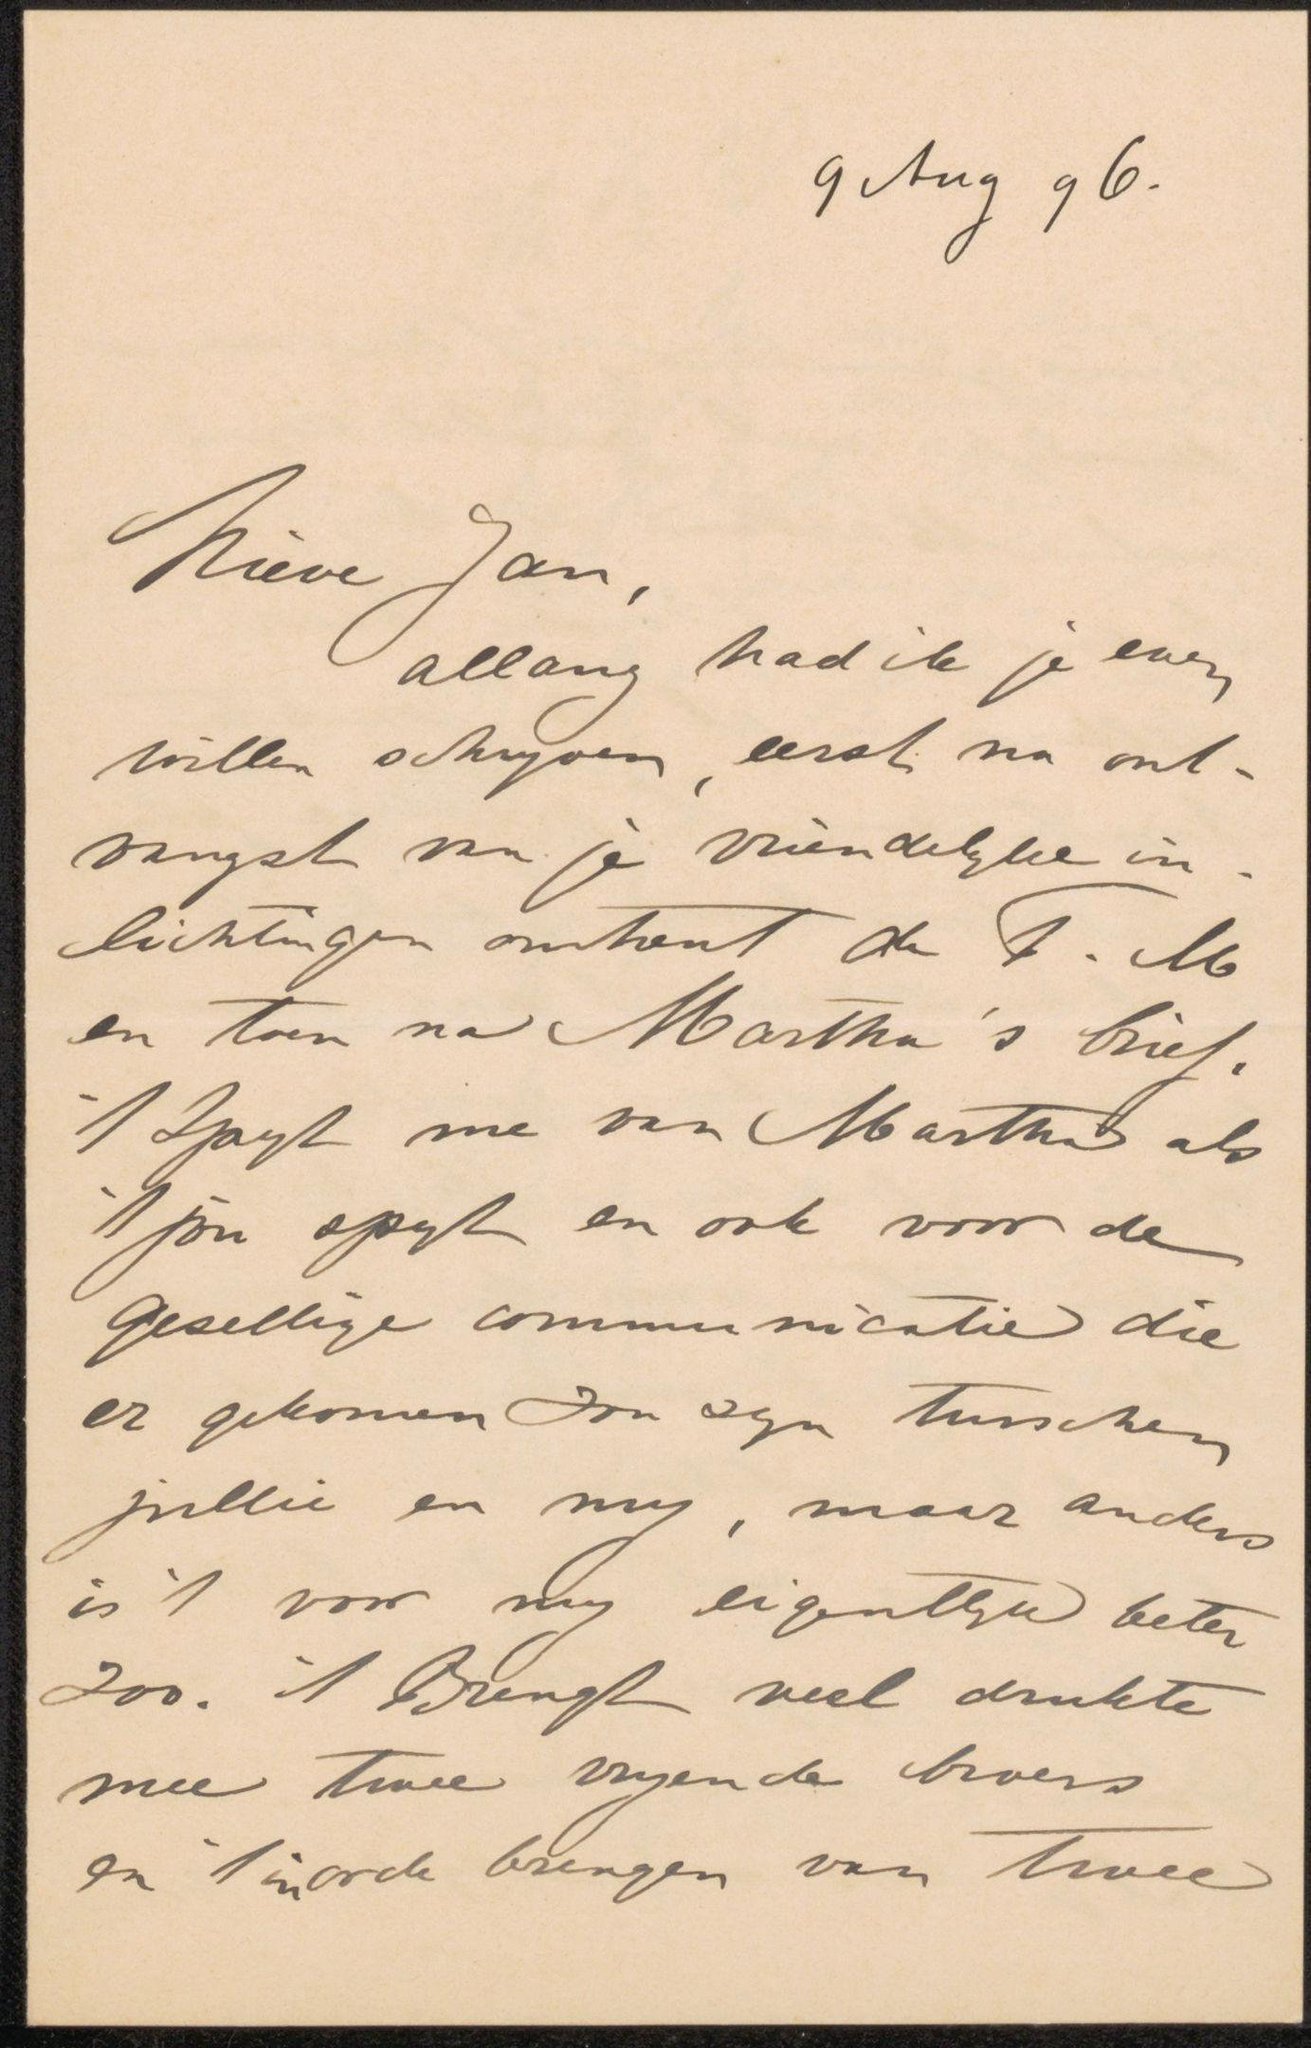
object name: letter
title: Brief aan Jan Veth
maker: wally moes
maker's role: draughtsman, print maker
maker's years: 1856-1918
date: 1874-1918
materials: ink, paper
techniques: pen, writing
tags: painter, jan veth, martha salomon, drawing, painting (including book-illumination, miniature-painting)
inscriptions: collector's mark: ‘RPK’